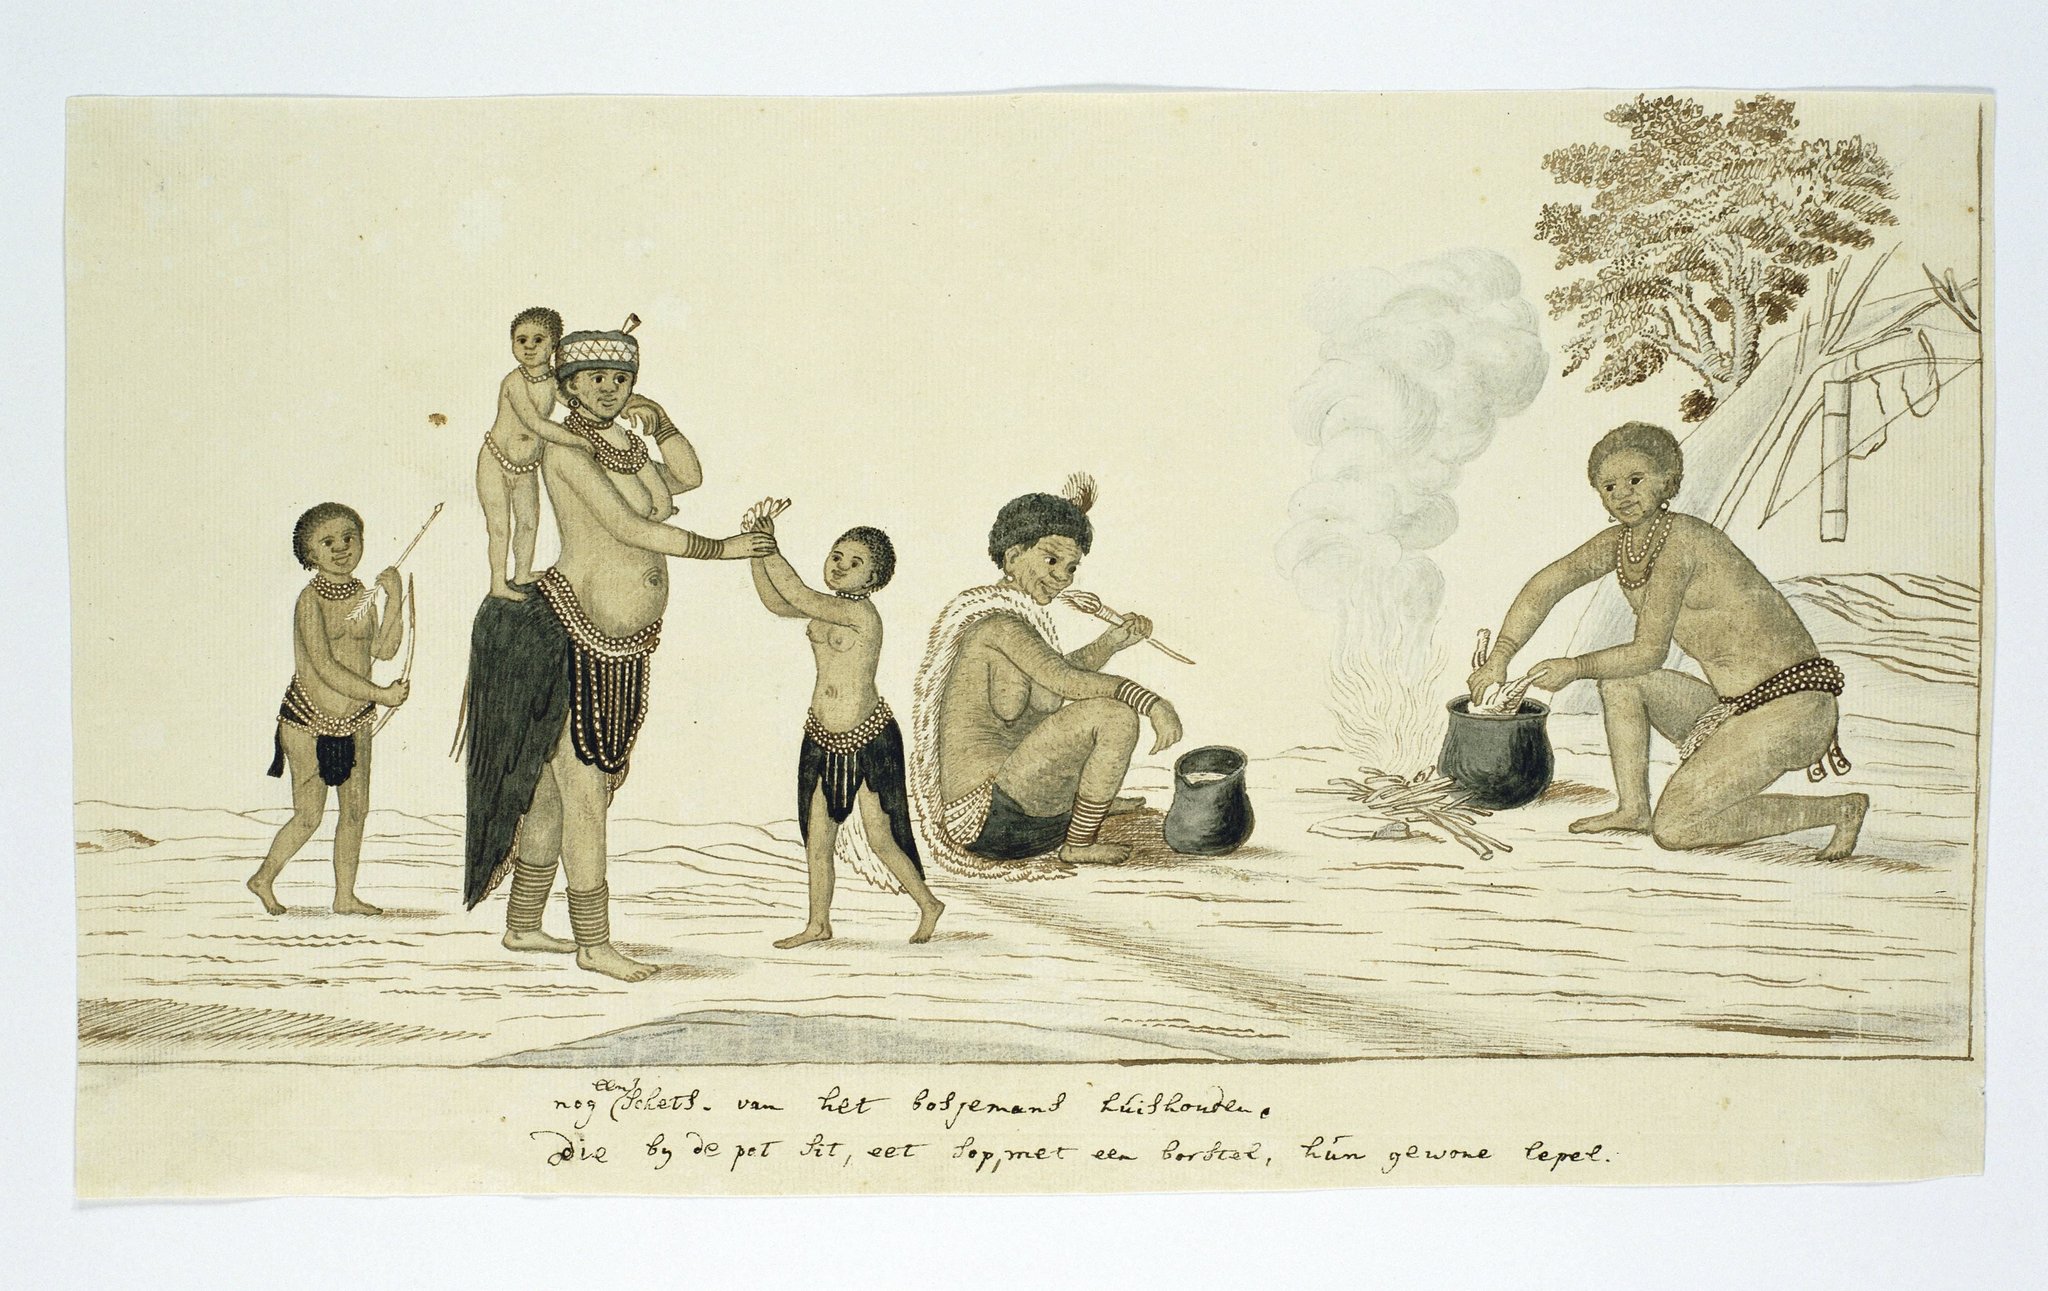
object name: album leaf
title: San (or Bushman) homestead, with hearth and cooking-pots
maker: robert jacob gordon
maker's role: draughtsman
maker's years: 1743-1795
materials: chalk, paint, ink, paper, pencil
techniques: brush, pen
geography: cape province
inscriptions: annotation: ‘nog een schets van het bosjemans huishouden, / die bij de pot Sit, eet Sop met een borstel, hun gewone lepel.’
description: Boesman (Bosjesman)-huishouden rond de kookpotten, waaruit soep met een borstel wordt gegeten; een jonge vrouw heeft een kind op haar karakteristiek forse achterwerk staan.